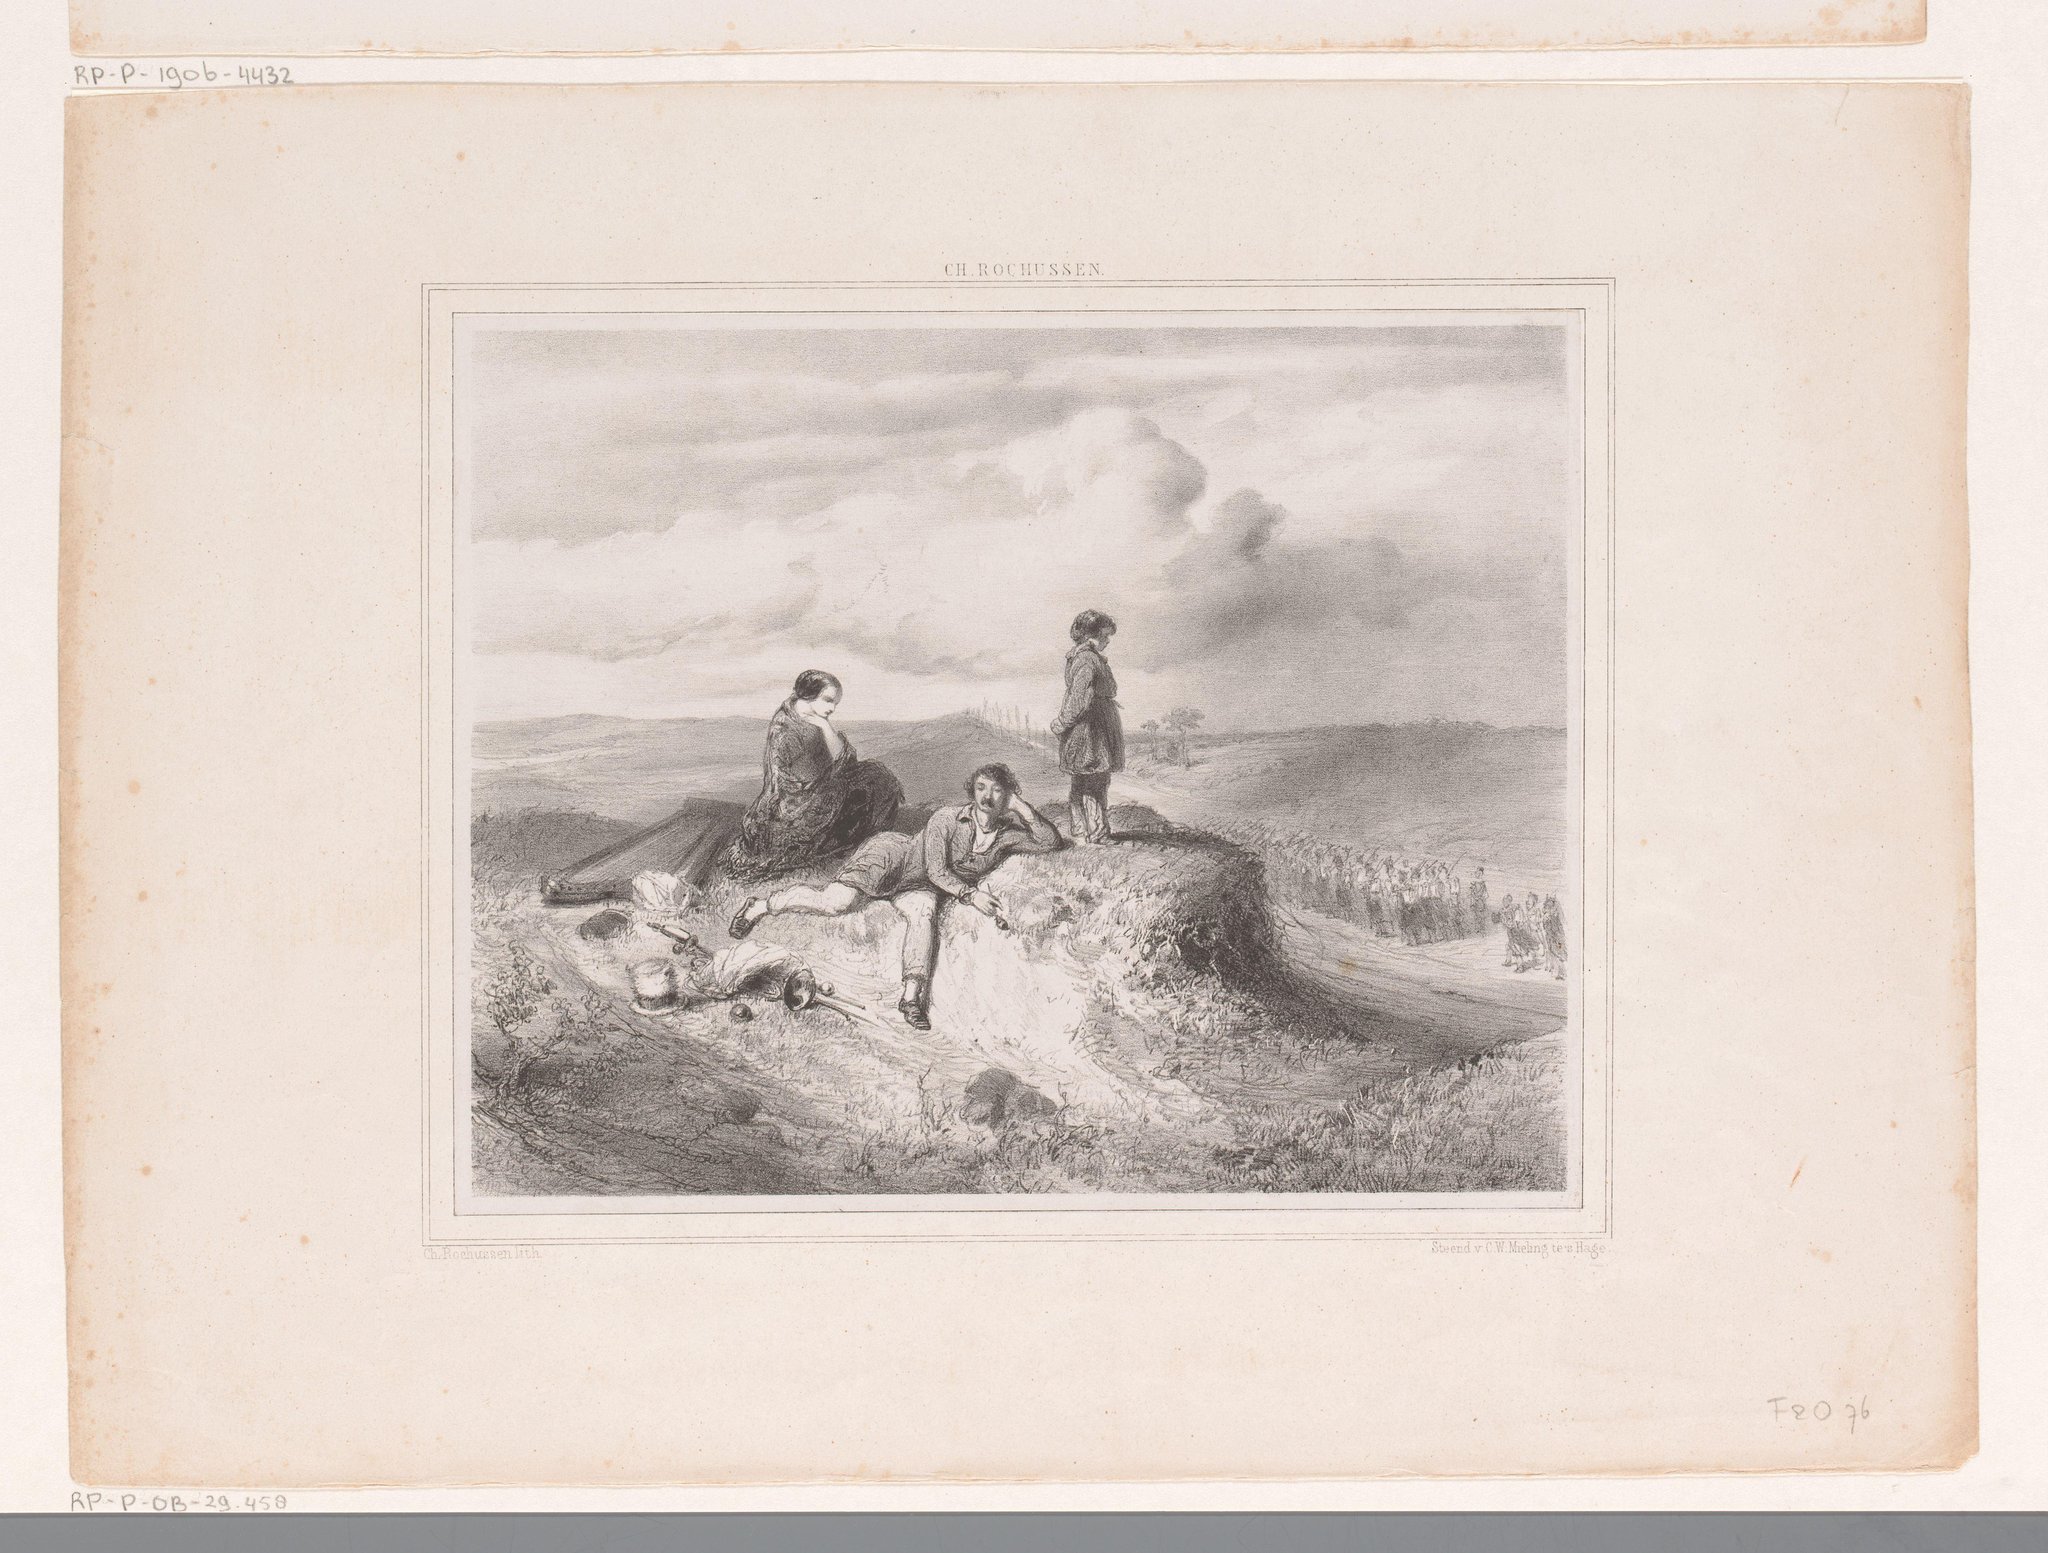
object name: print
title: Rustende man, vrouw en kind op heuvel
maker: charles rochussen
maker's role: draughtsman, painter, print maker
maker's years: 1814-1894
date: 1845-1846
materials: paper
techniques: lithograph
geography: the hague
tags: (high) hill, resting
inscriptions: collector's mark: Lugt 2228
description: Op een heuvel liggen een man en vrouw te rusten. Een kind kijkt naar een optocht onder aan de heuvel. Bij de figuren liggen een harp, goeden, trompet en sabels.